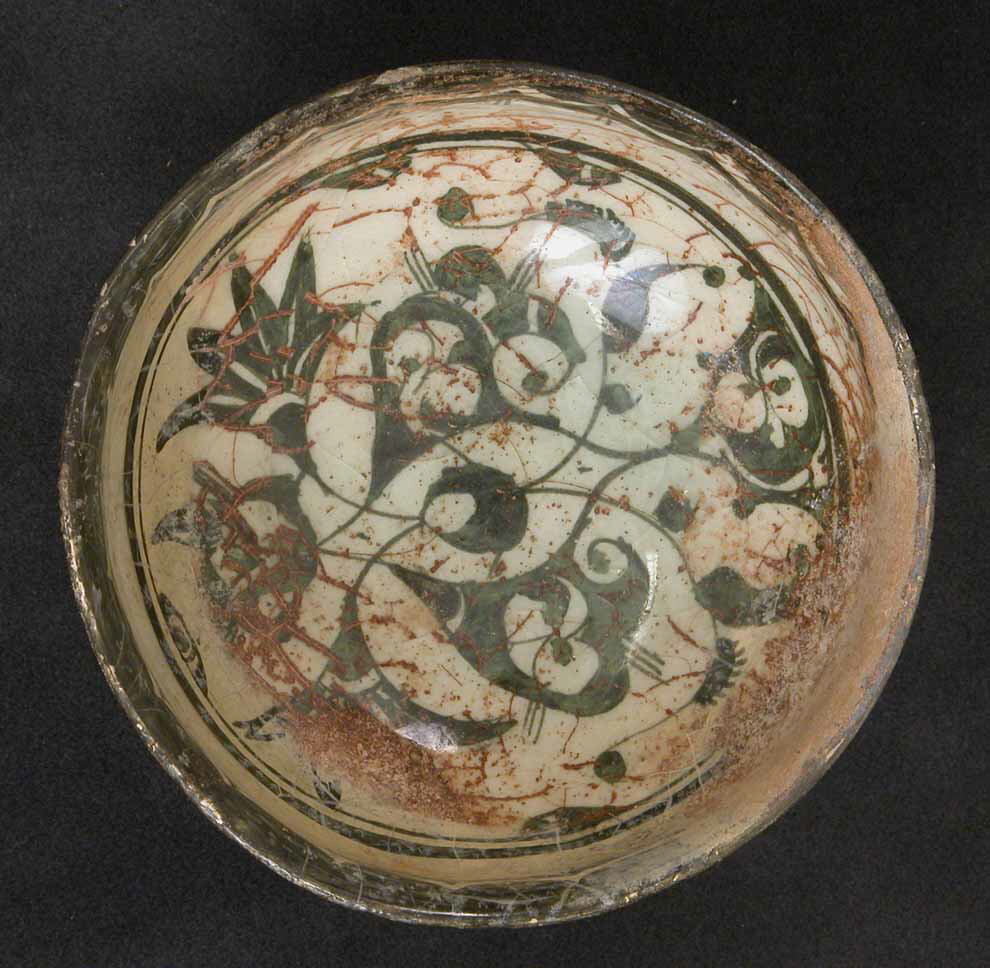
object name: bowl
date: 1101-1300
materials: glaze, stonepaste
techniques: painting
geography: syria